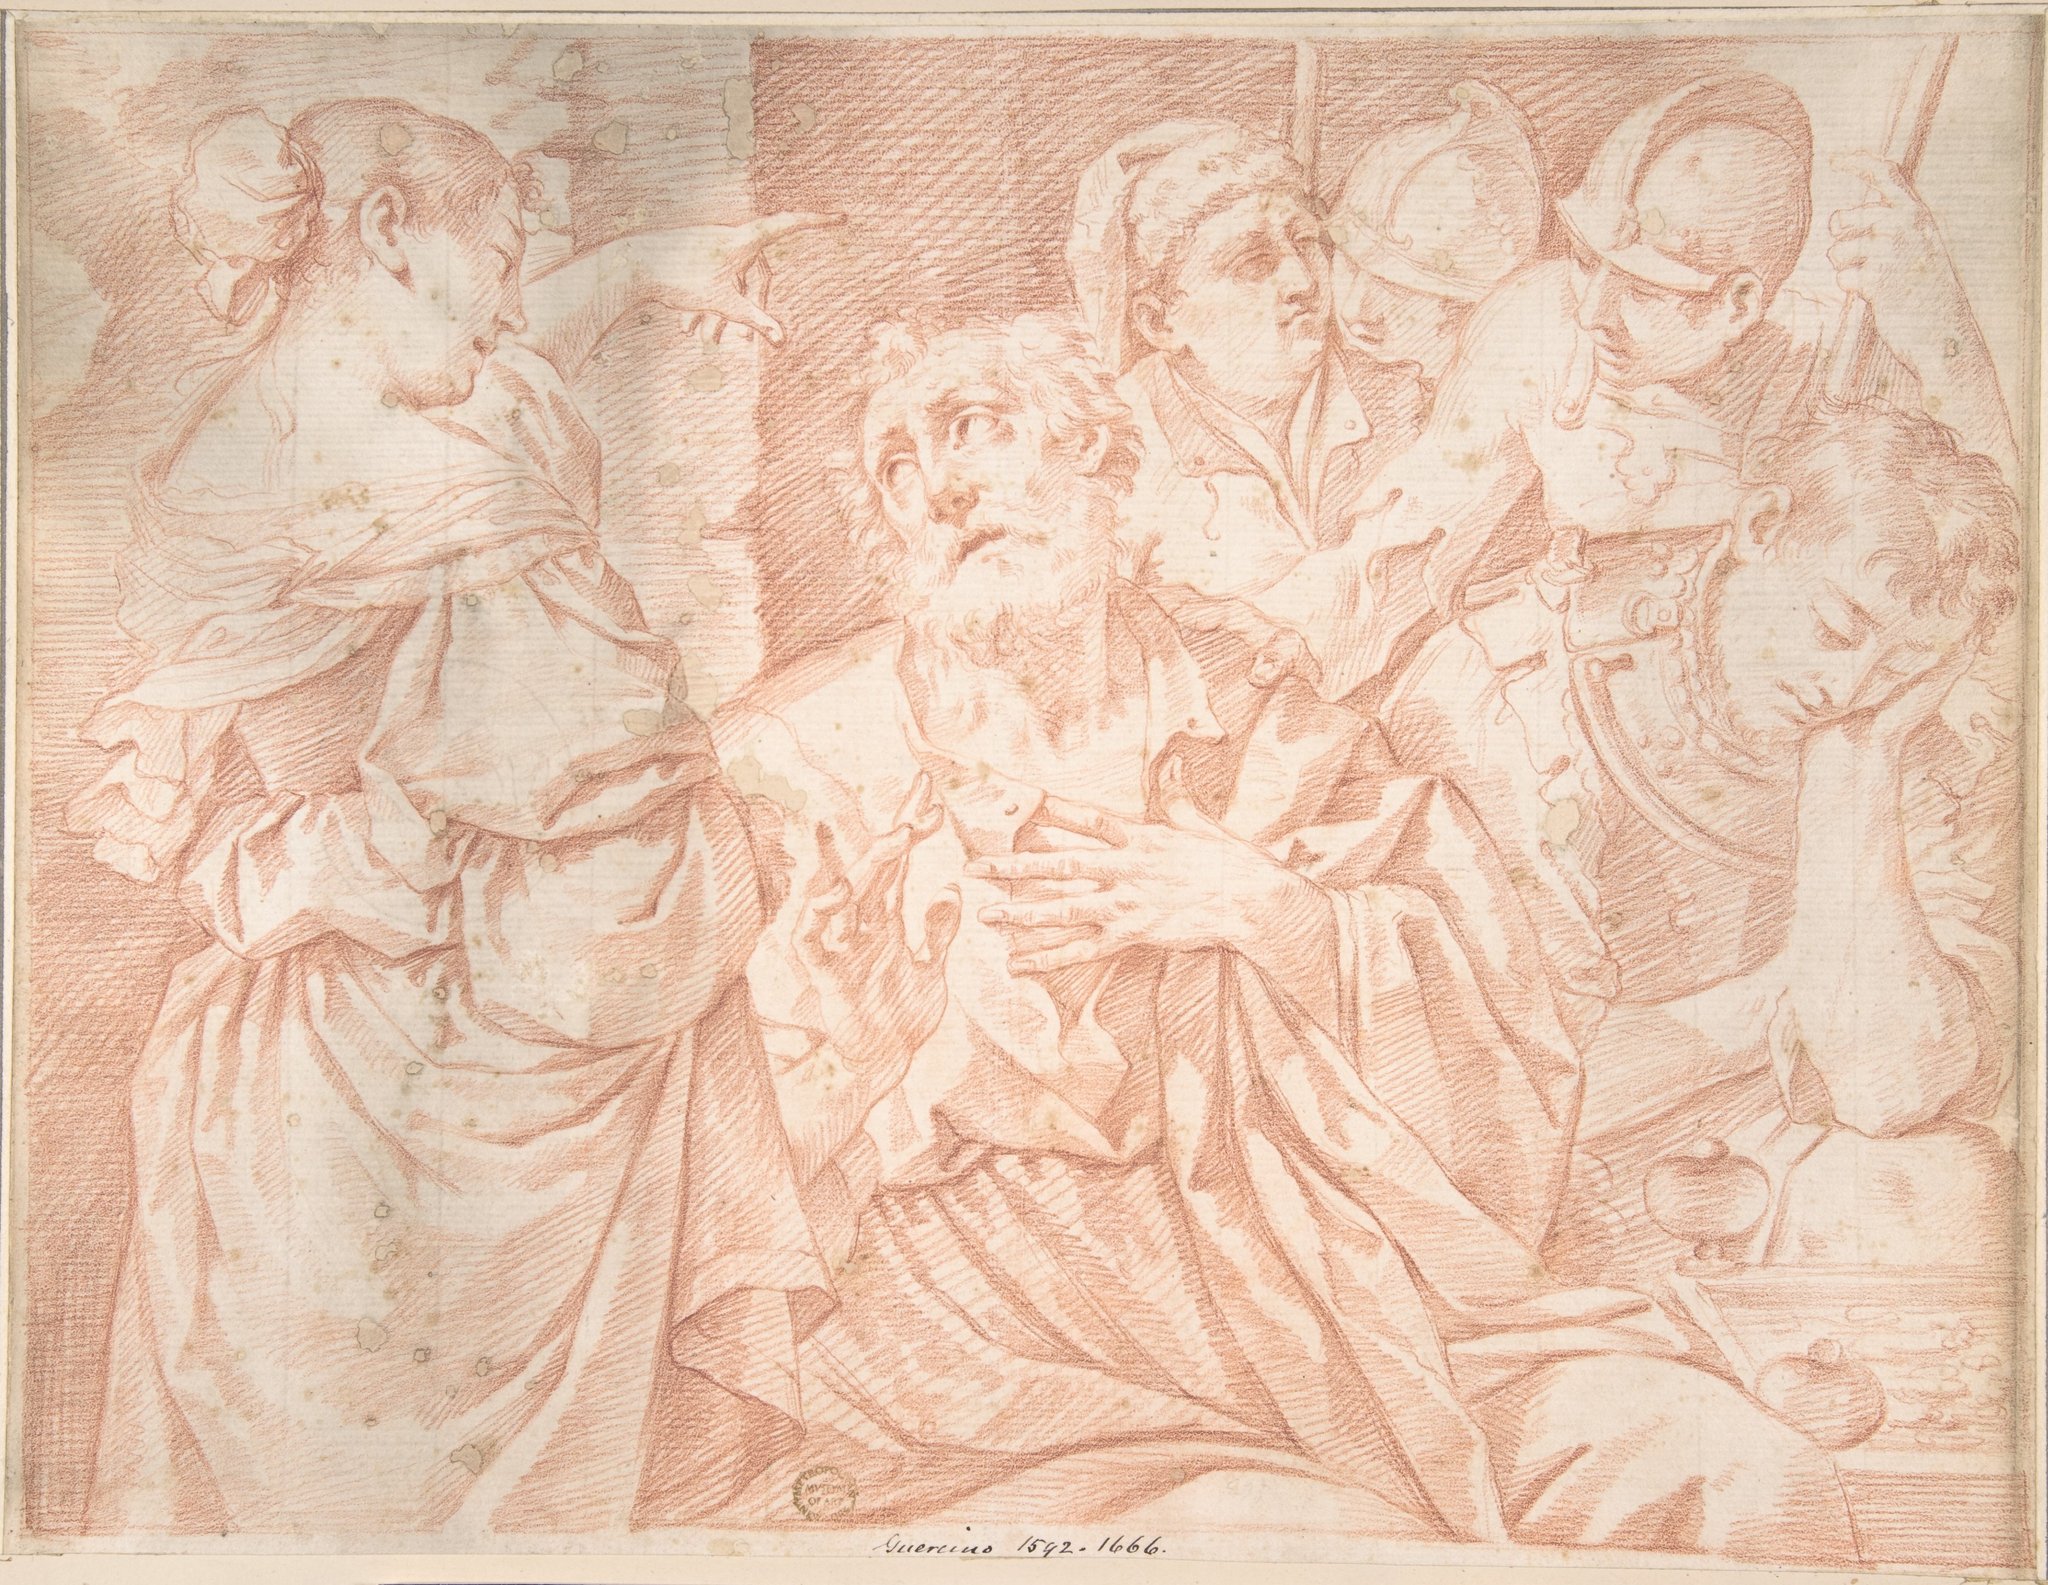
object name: drawing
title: Peter Denying Christ, engraver's copy after a painting by Lorenzo Pasinelli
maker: anonymous, italian, roman-bolognese, 17th century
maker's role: artist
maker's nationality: italian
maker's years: 1600-1700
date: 1601-1700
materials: chalk, paper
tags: soldiers,women,christ,saint peter